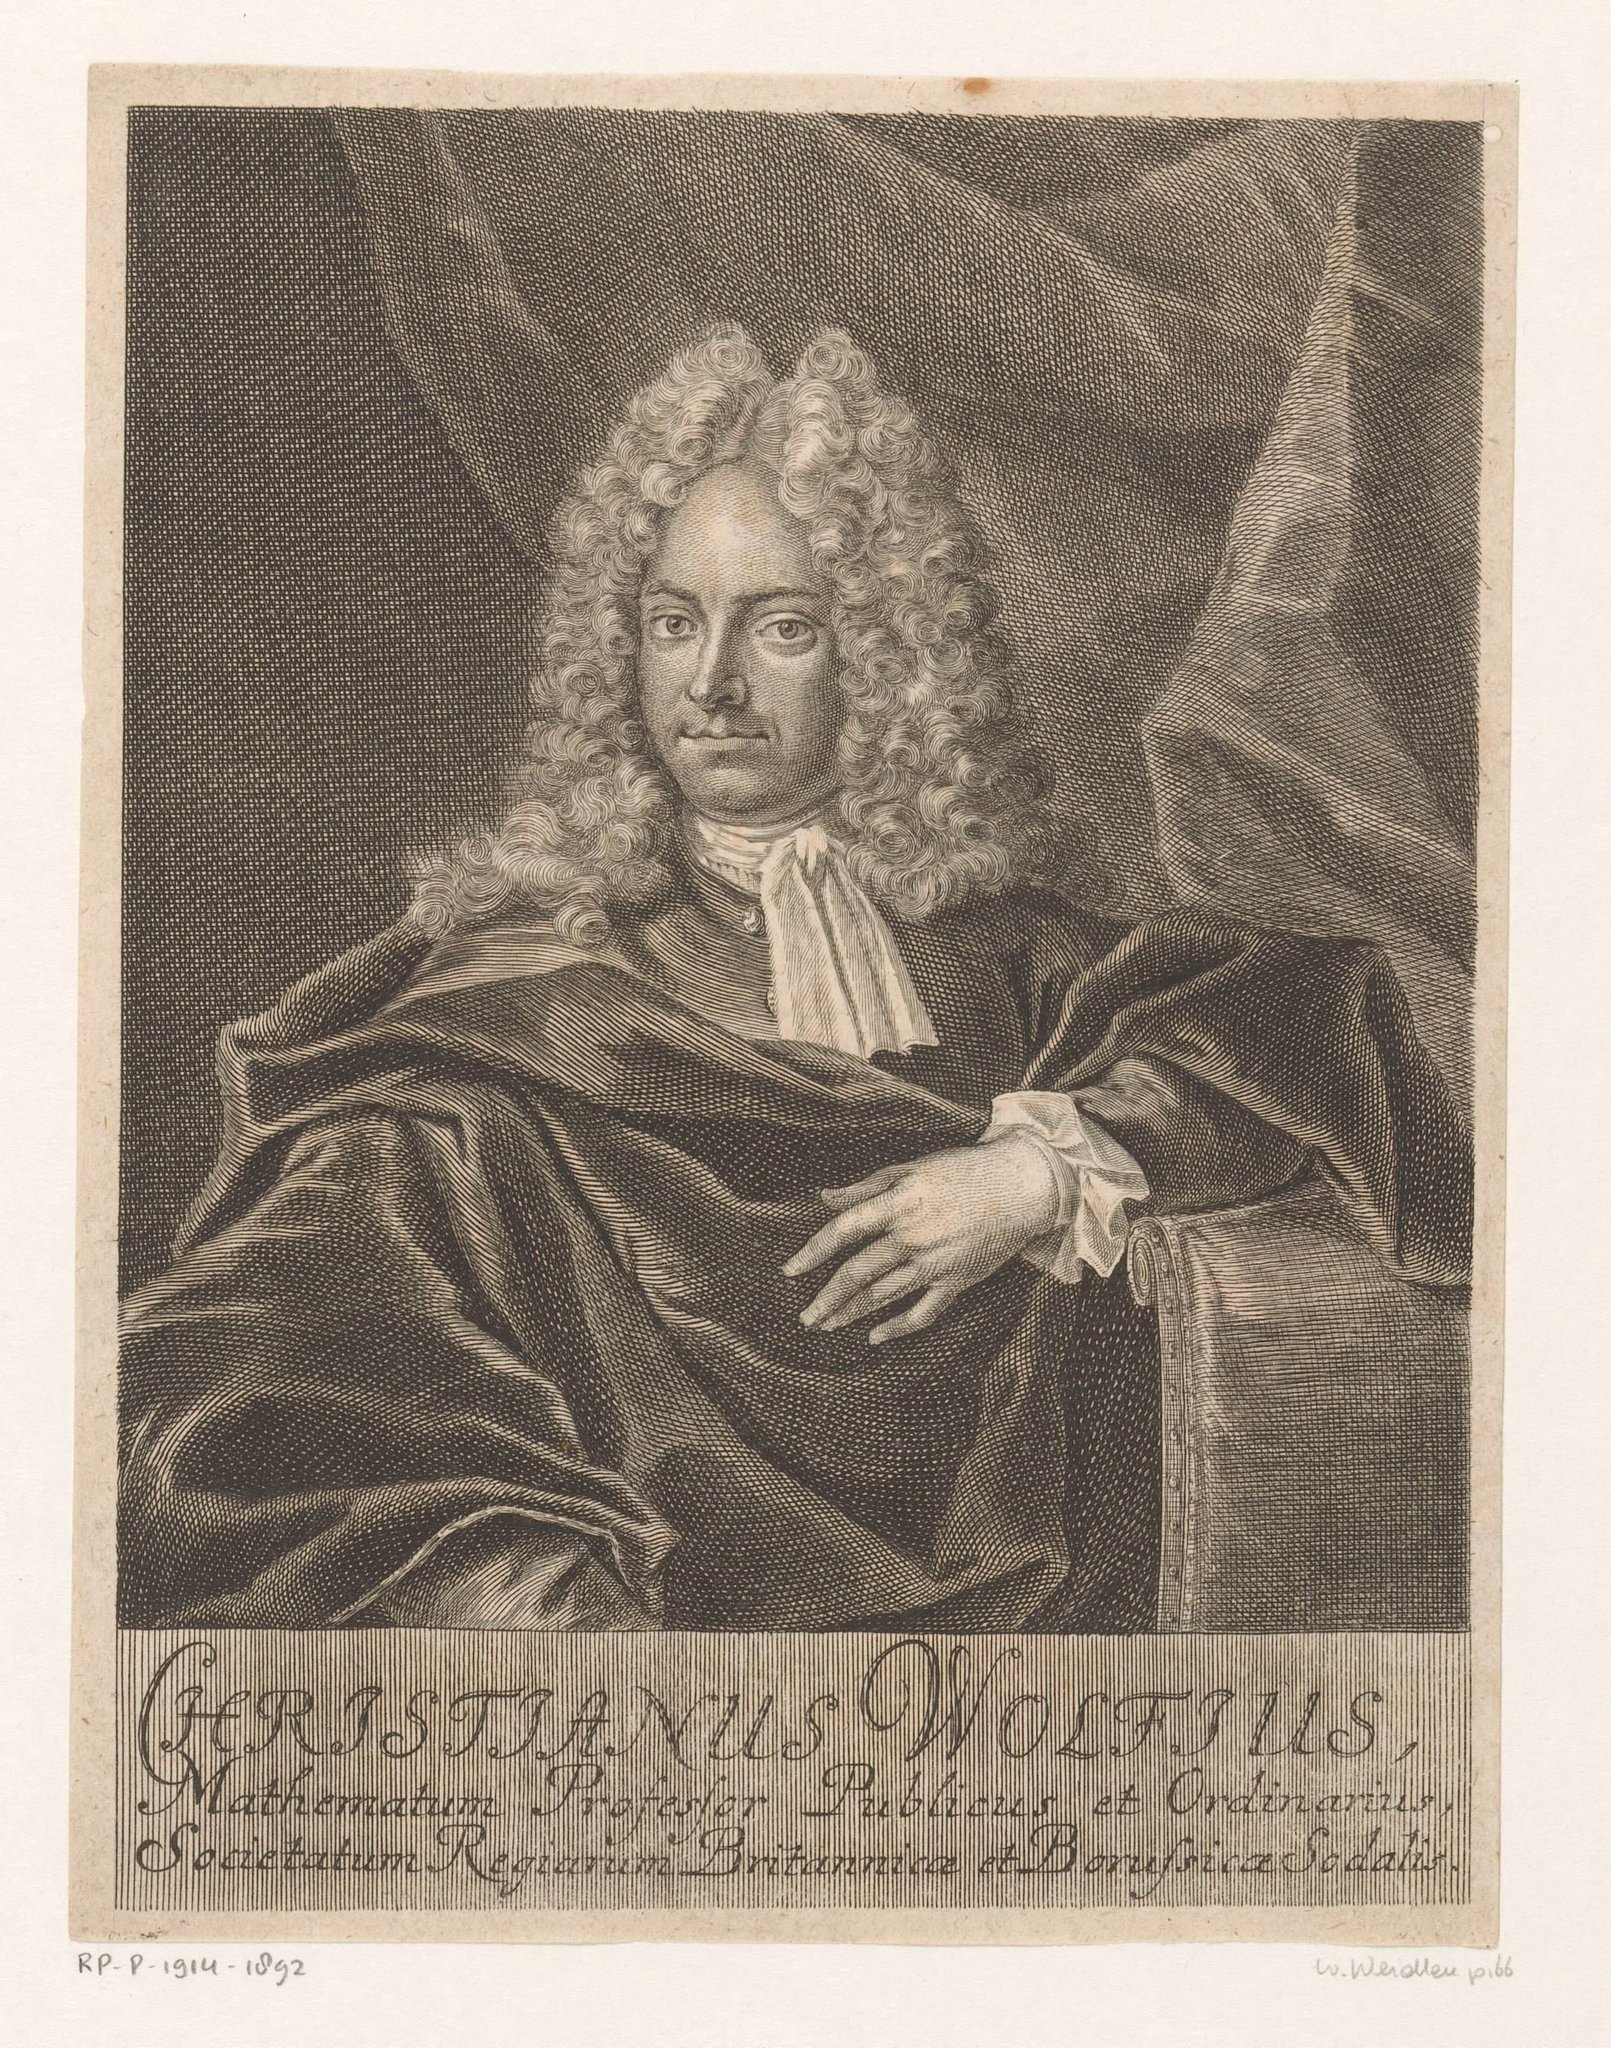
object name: print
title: Portret van Christian Wolff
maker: martin bernigeroth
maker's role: print maker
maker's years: 1670-1733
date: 1710-1733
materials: paper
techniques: engraving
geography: leipzig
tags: historical persons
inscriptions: collector's mark: Lugt 2228